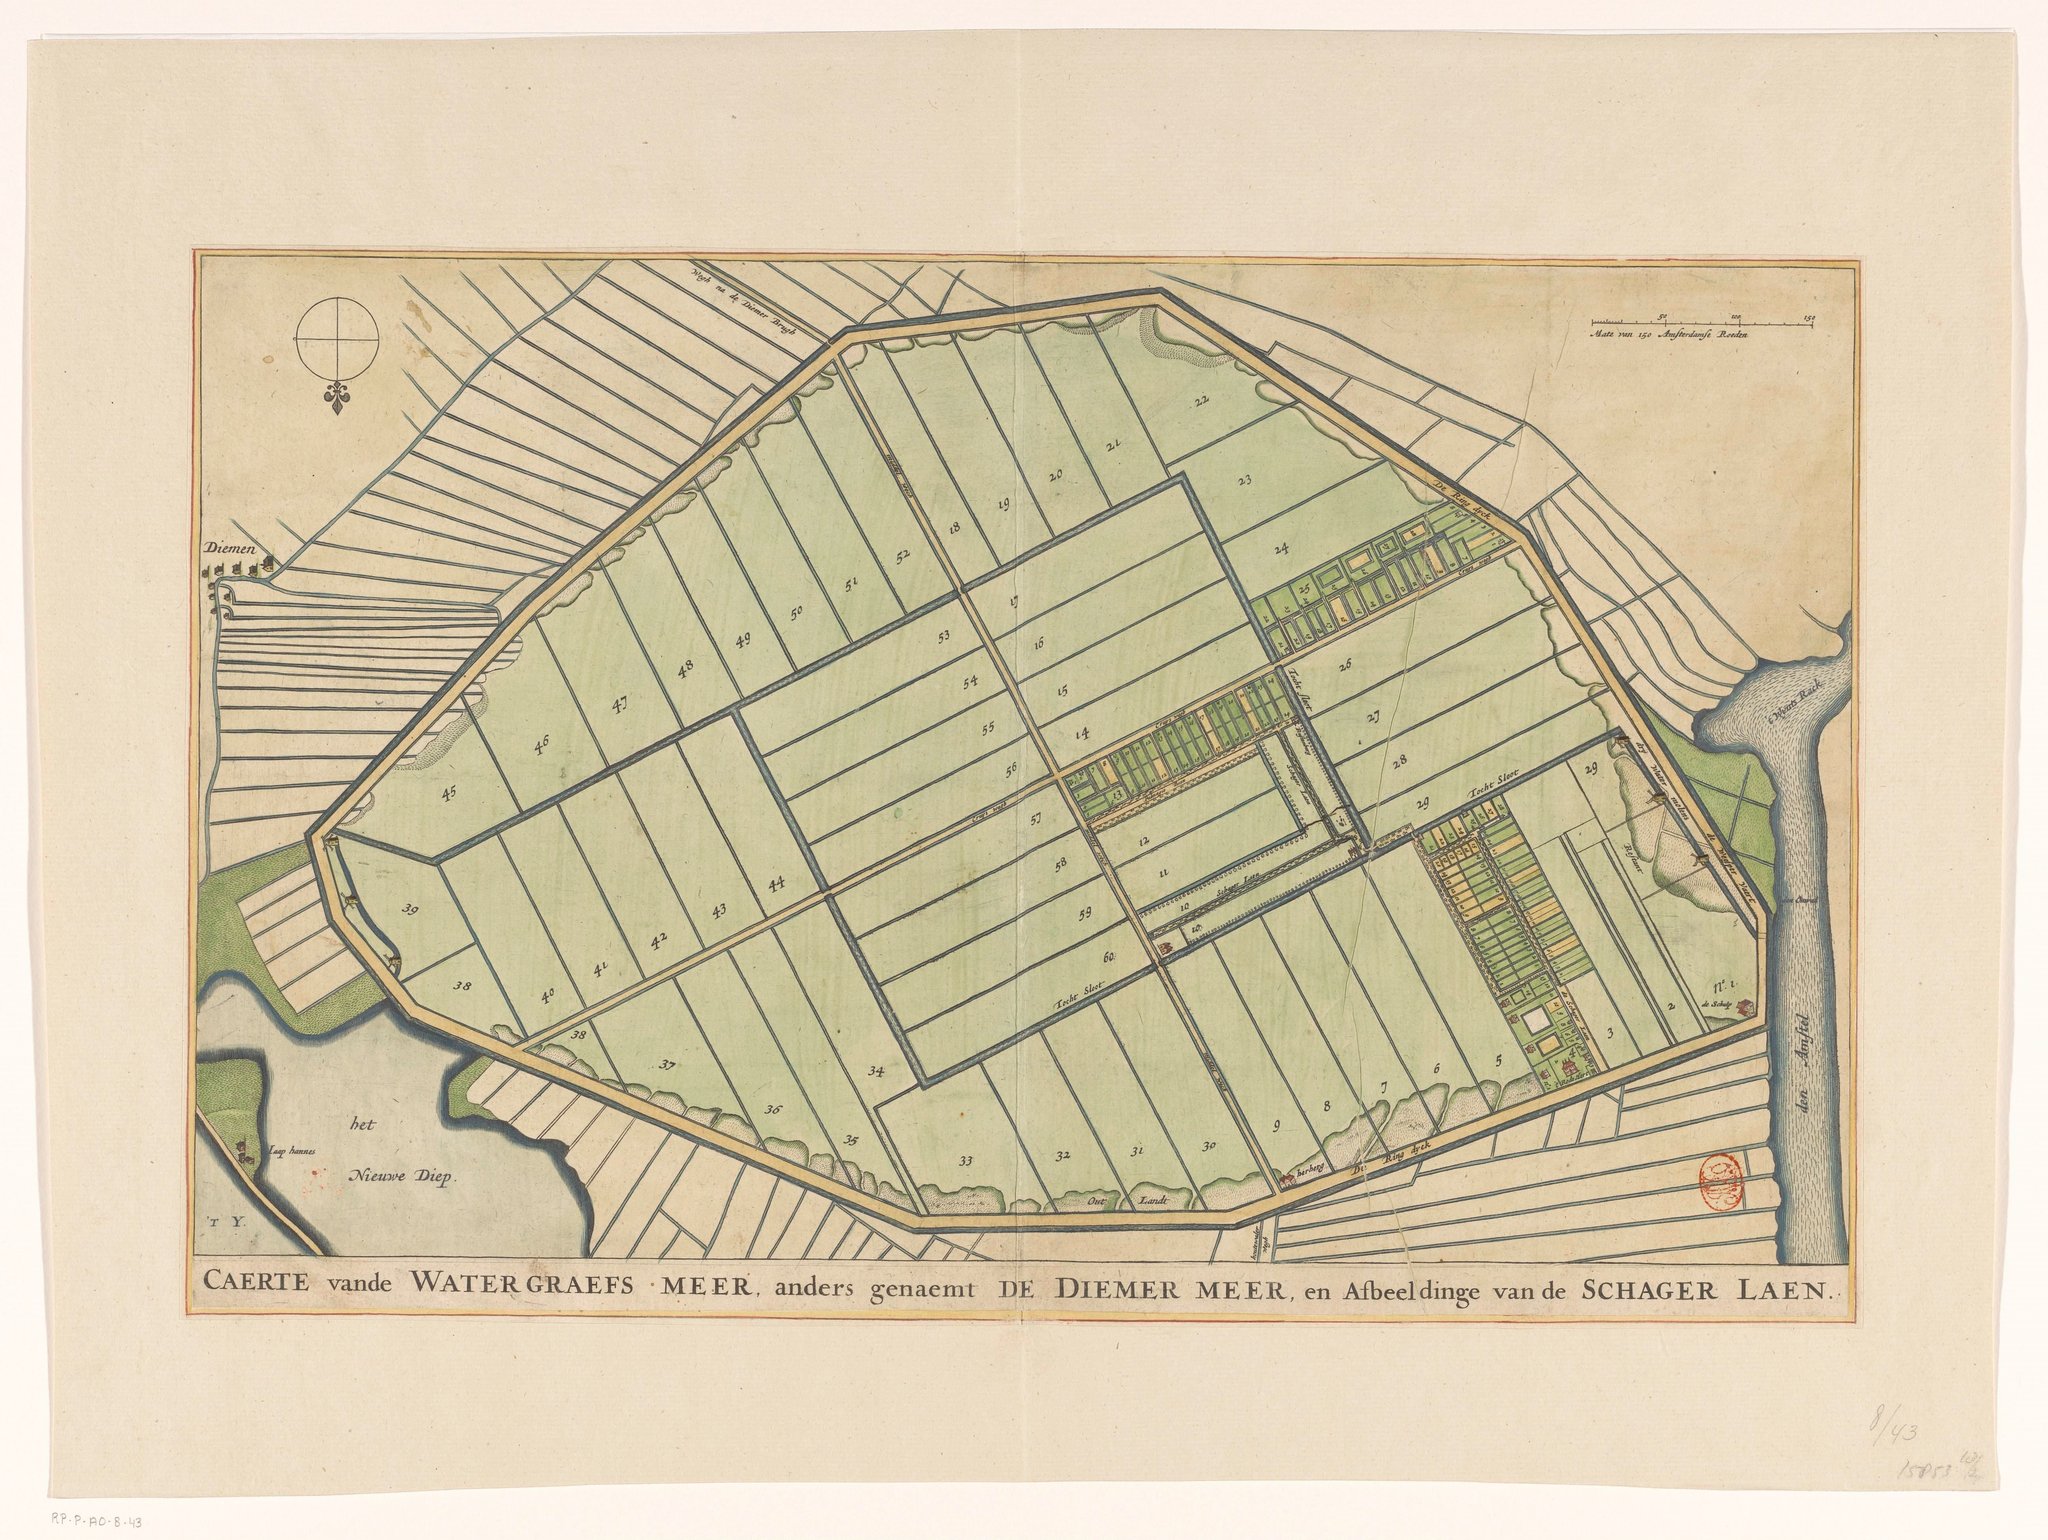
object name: print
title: Kaart van de Diemermeerpolder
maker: Anonymous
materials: paper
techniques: engraving, hand coloring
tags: maps of separate countries or regions, polder, reclaimed land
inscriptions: collector's mark: Lugt 195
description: Kaart van de Diemermeerpolder met verkaveling. Langs de onderkant de titel. Rechtsboven een schaalstok: Mate van 150 Amsterdamse roeden.